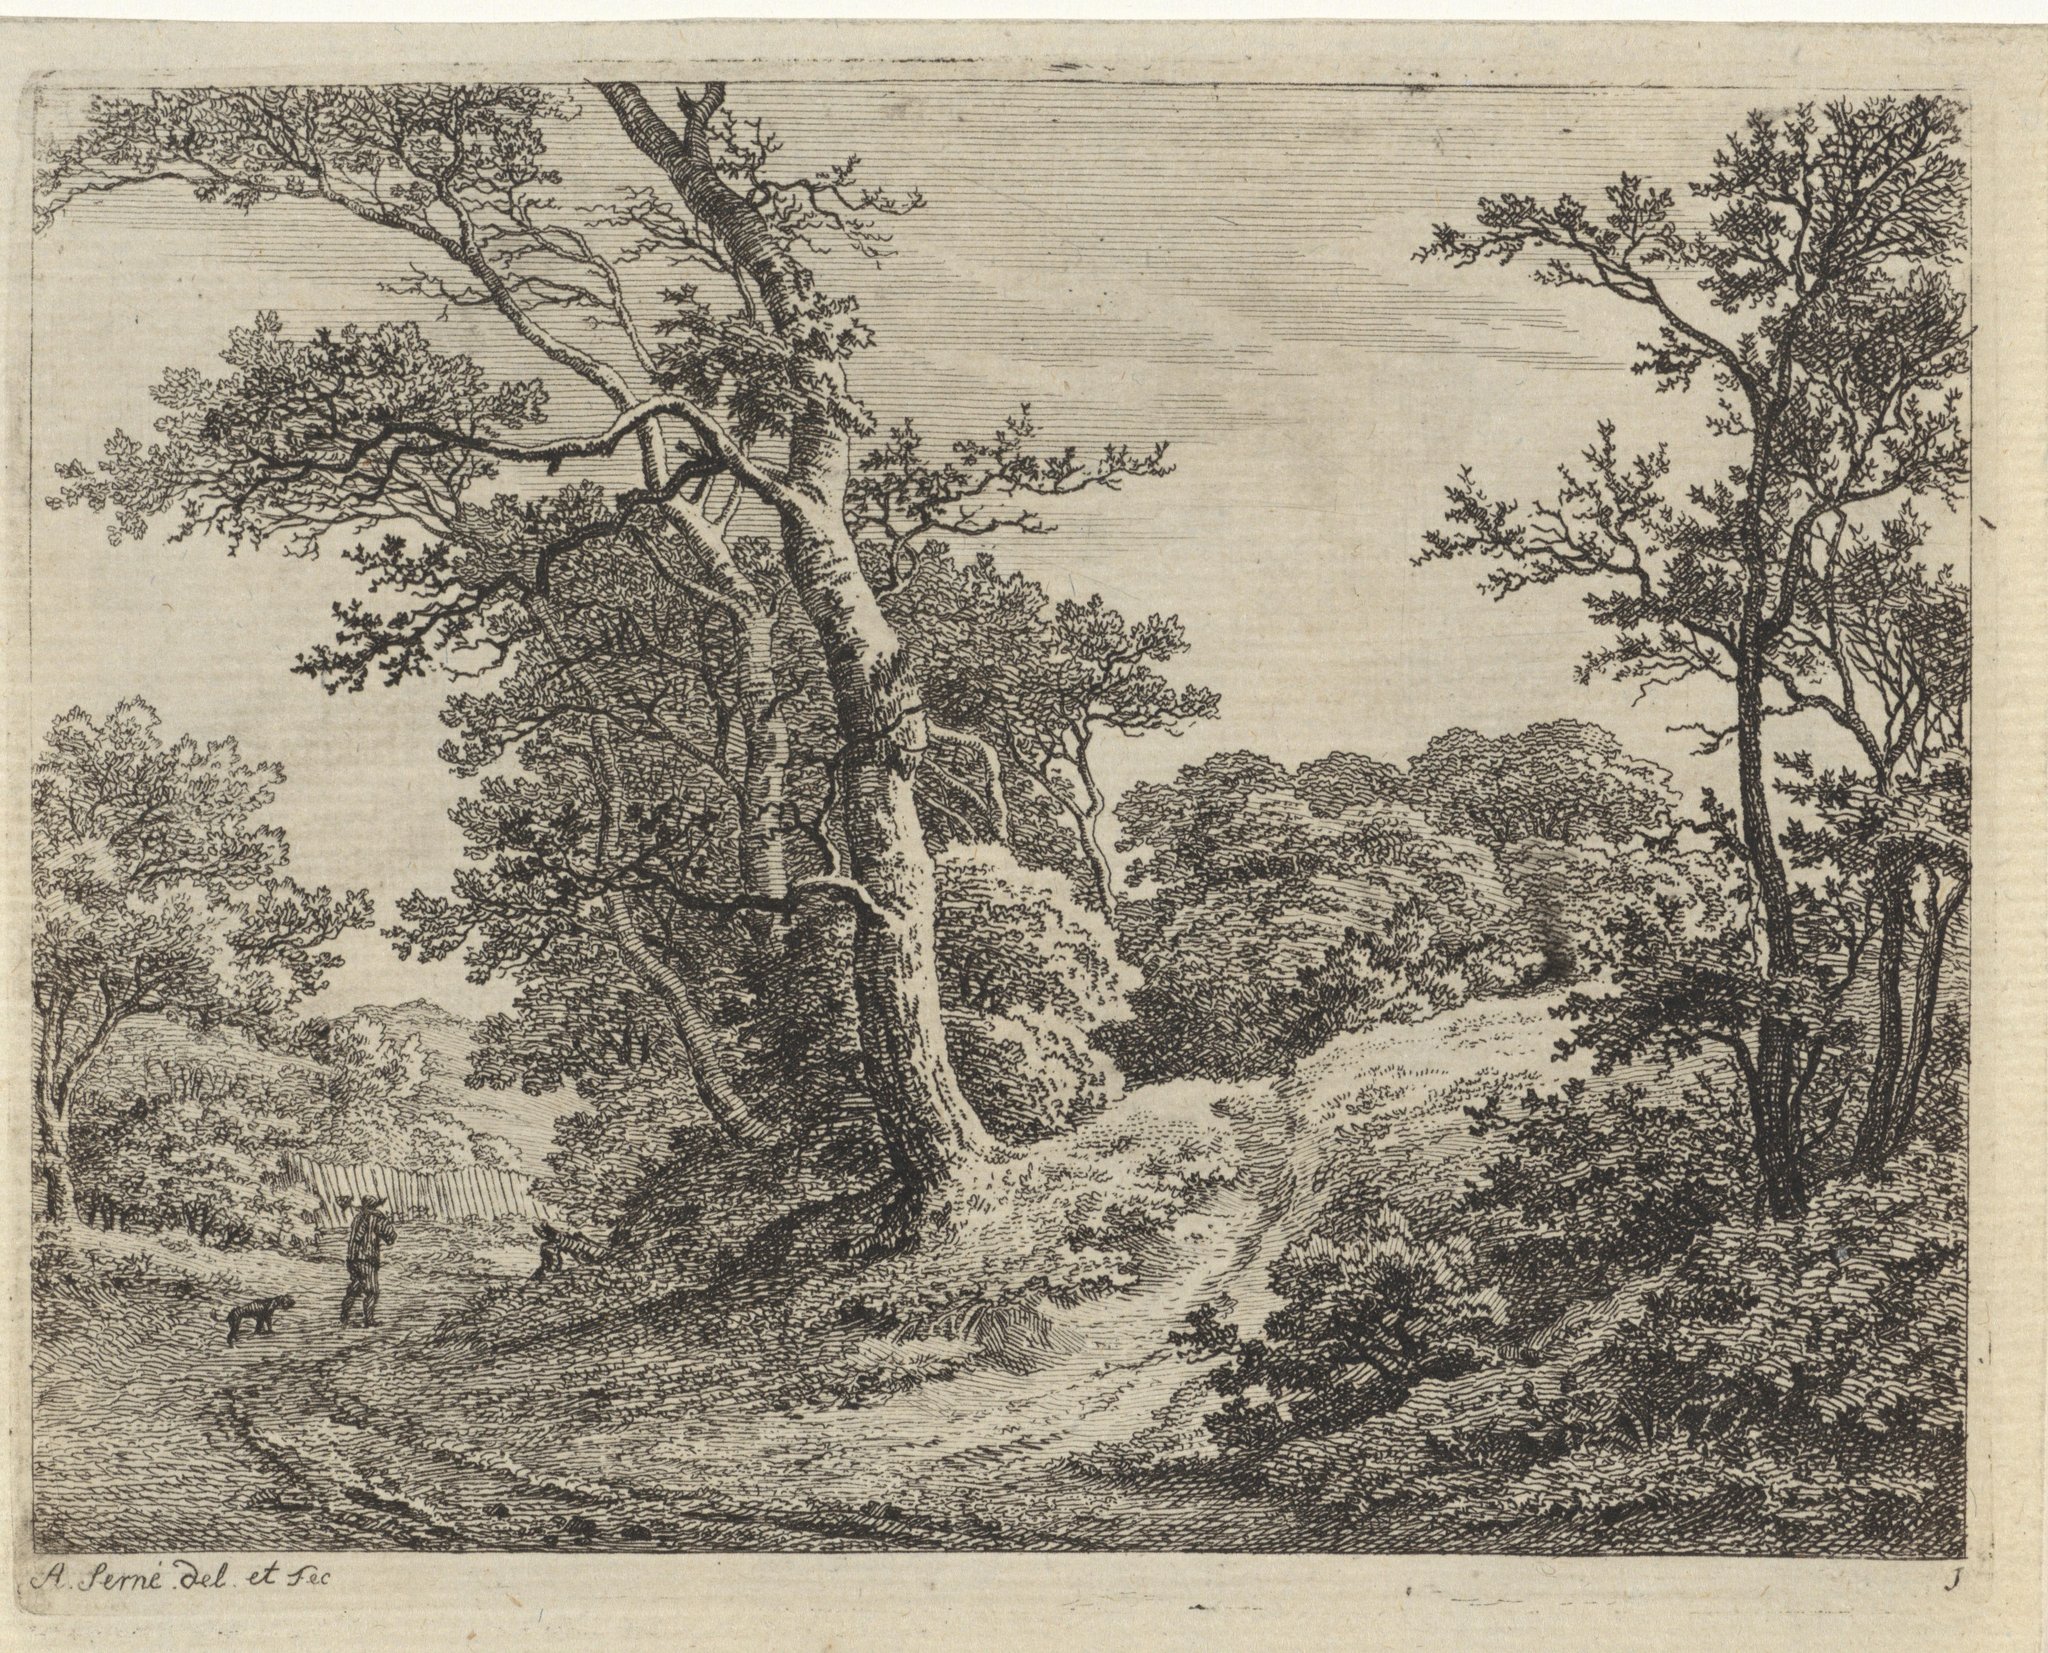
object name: print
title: Weg langs een met bomen begroeide heuvel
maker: adrianus serné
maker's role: print maker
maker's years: 1773-1853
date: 1783-1853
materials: paper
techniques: engraving, etching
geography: netherlands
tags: dog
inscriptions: collector's mark: Lugt 2228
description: Weg langs een met bomen begroeide heuvel. Op de weg loopt een man met een hond. Rechtsonder genummerd: 1.